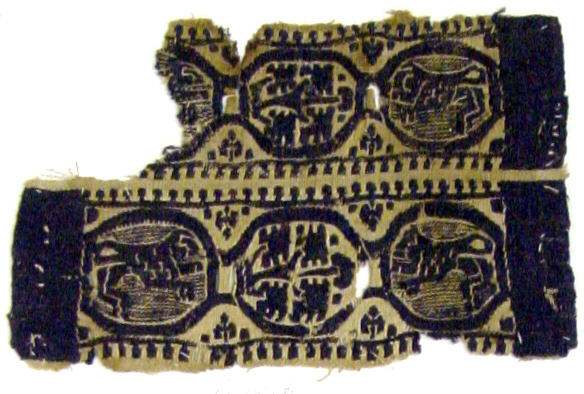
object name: textile fragment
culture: coptic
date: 300-600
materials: linen, wool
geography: egypt